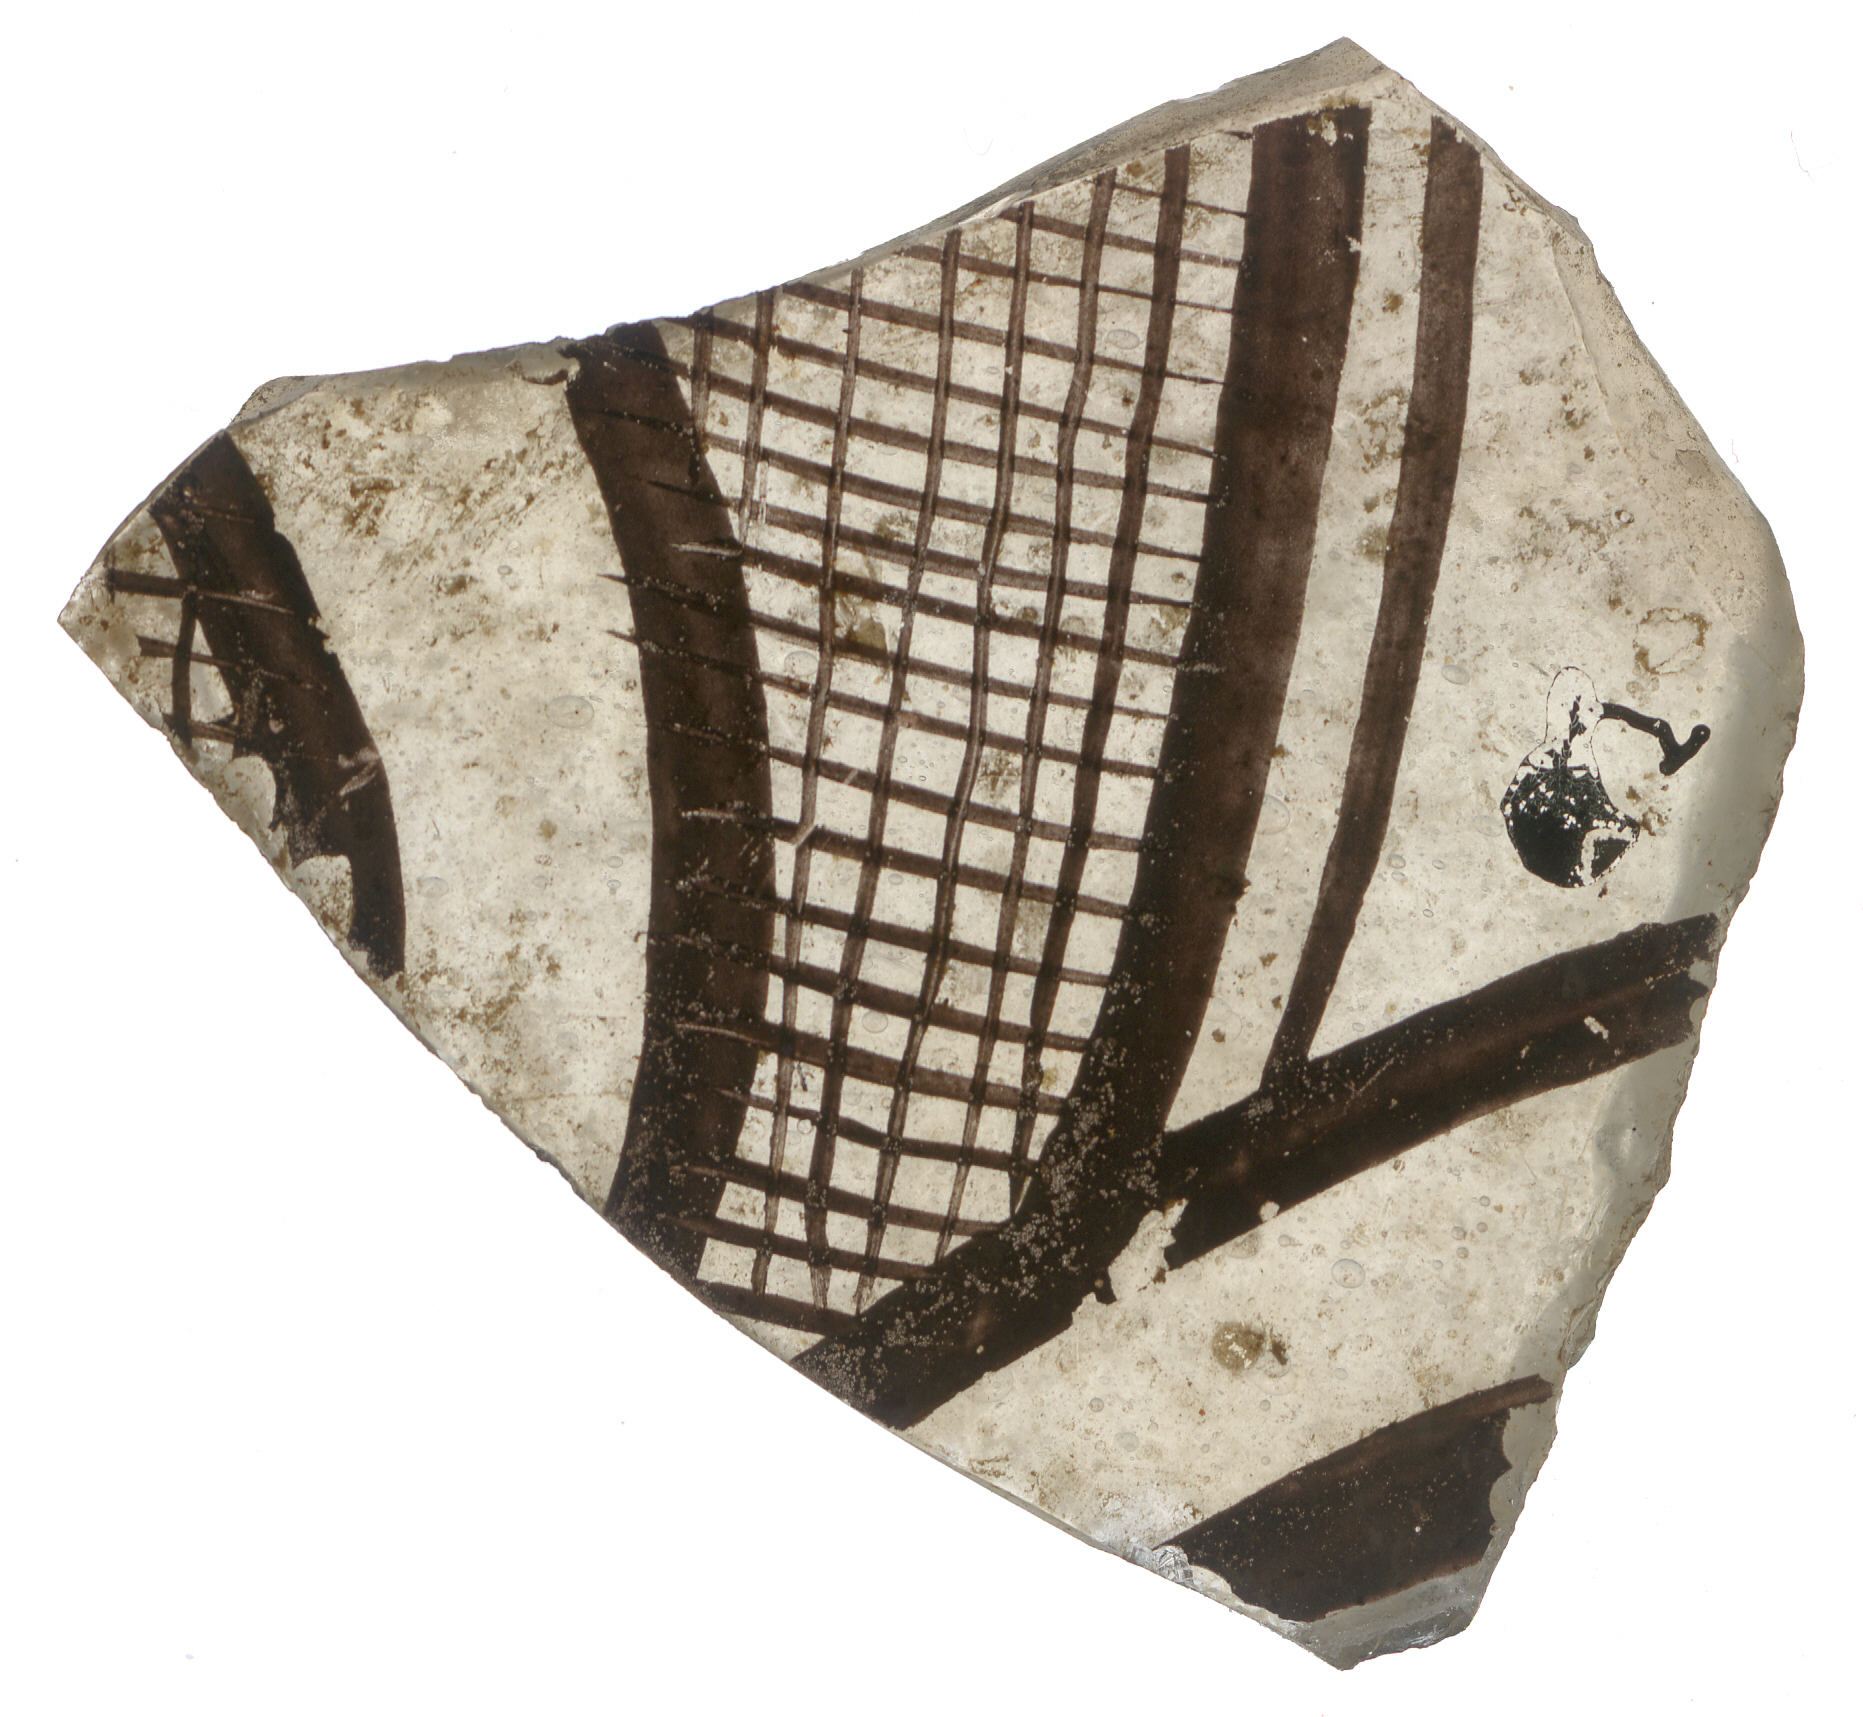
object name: fragment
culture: crusader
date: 1201-1300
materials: glass